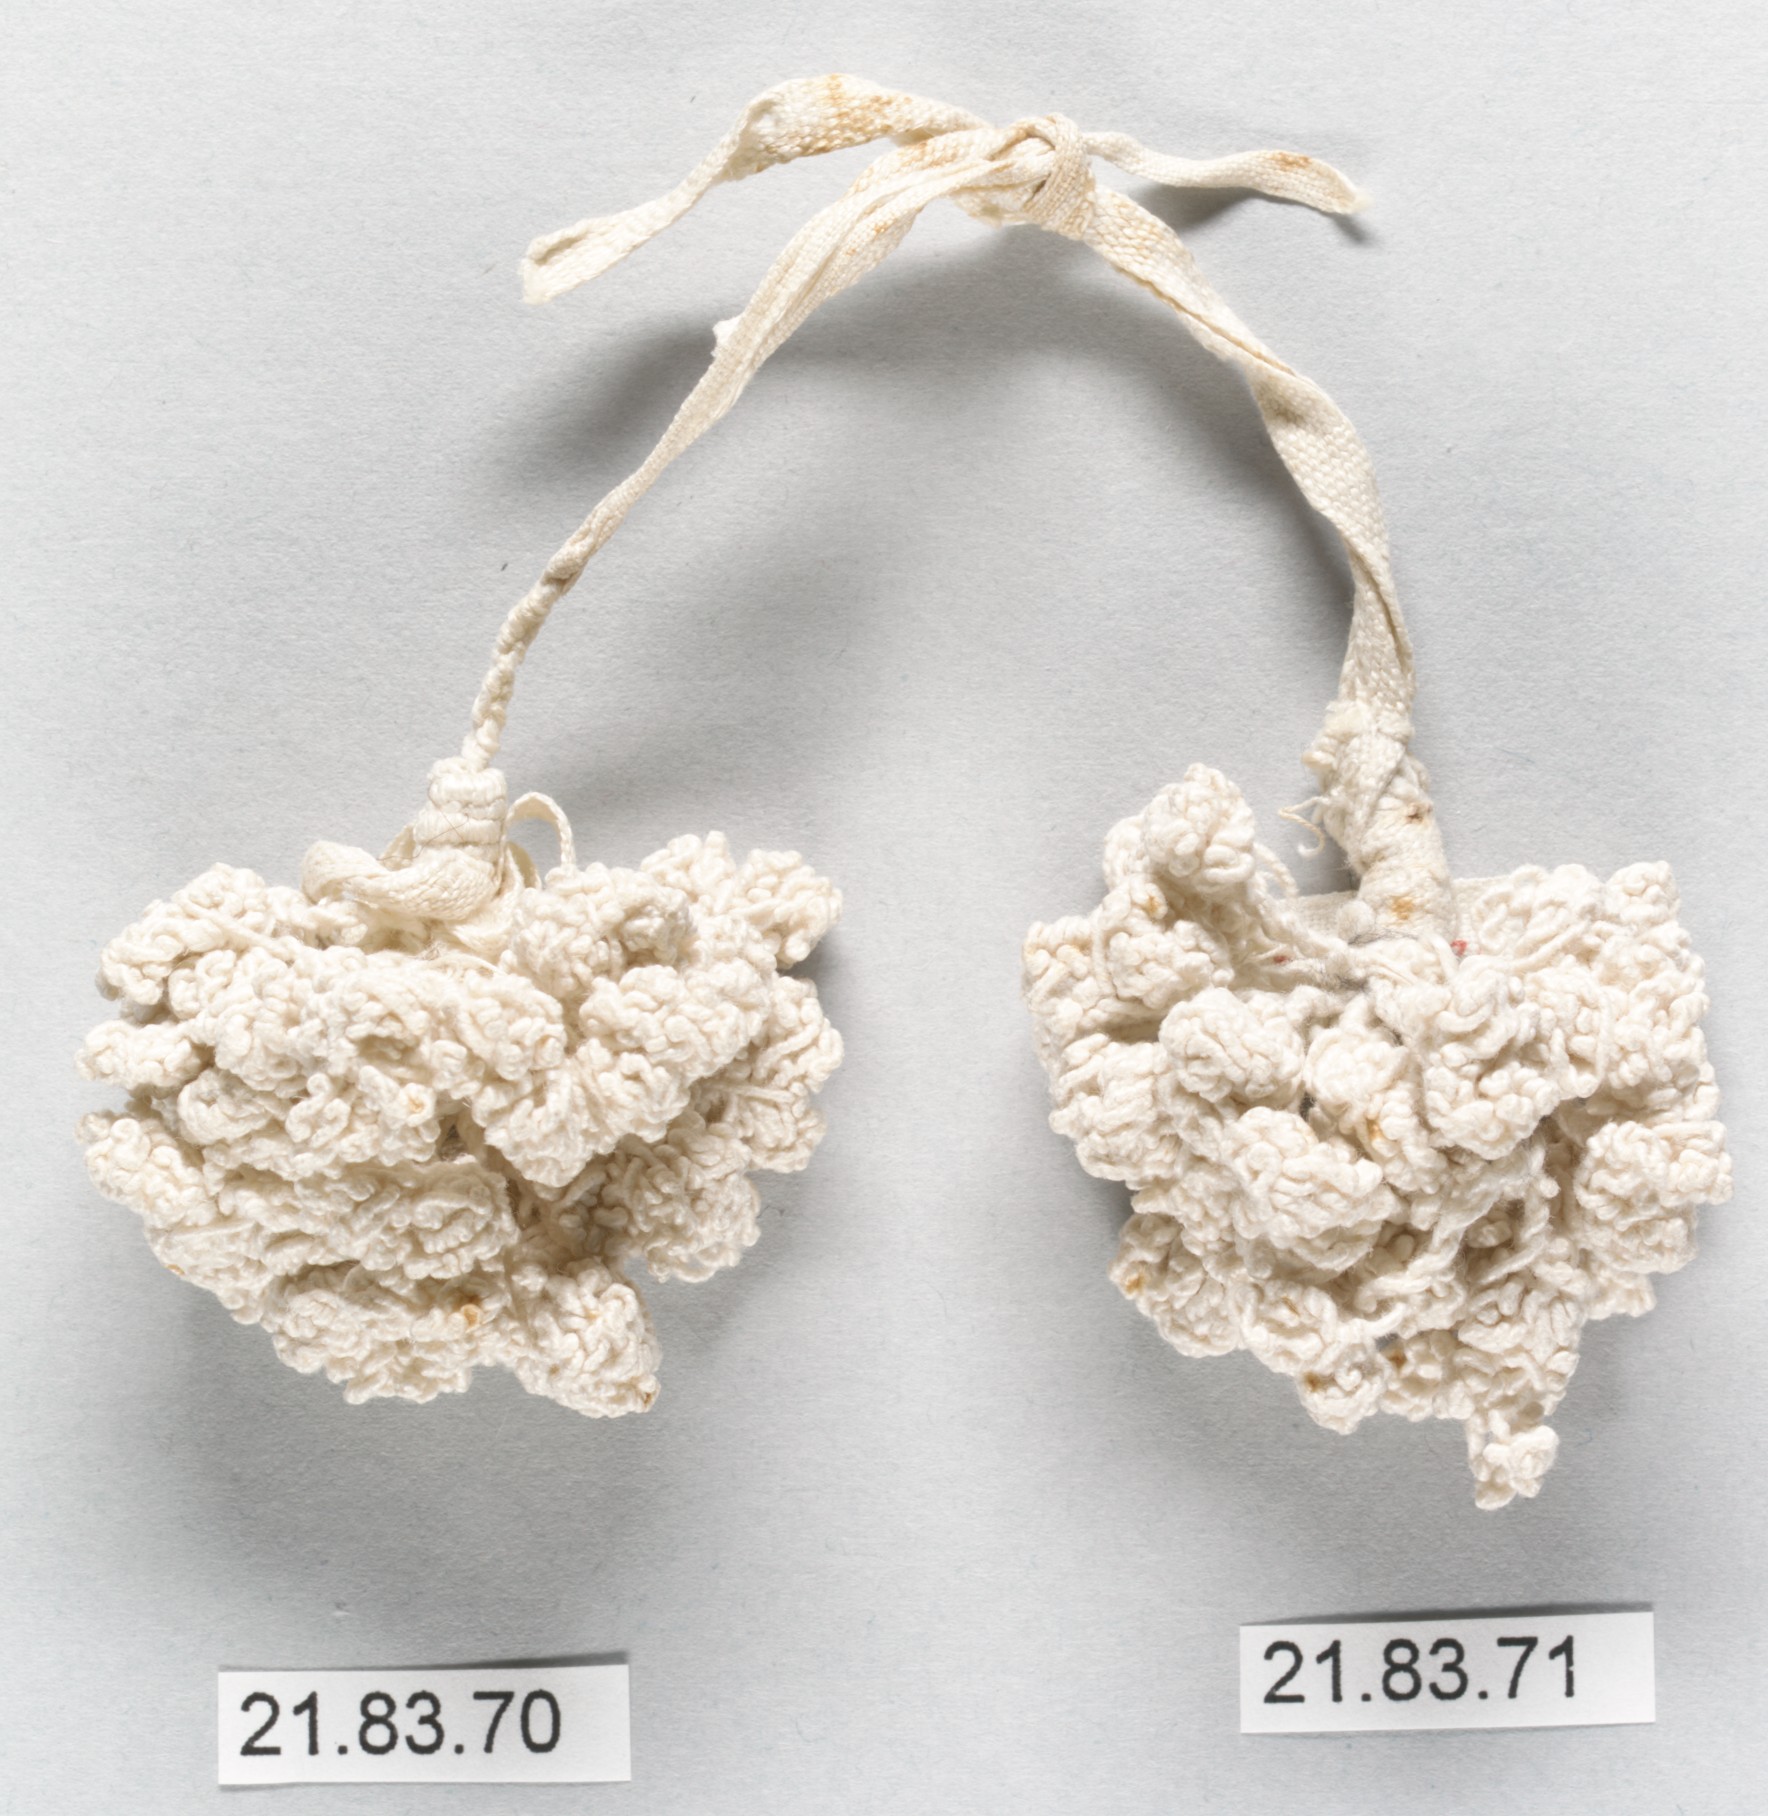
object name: tassel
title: Pair of tassels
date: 1601-1700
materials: linen